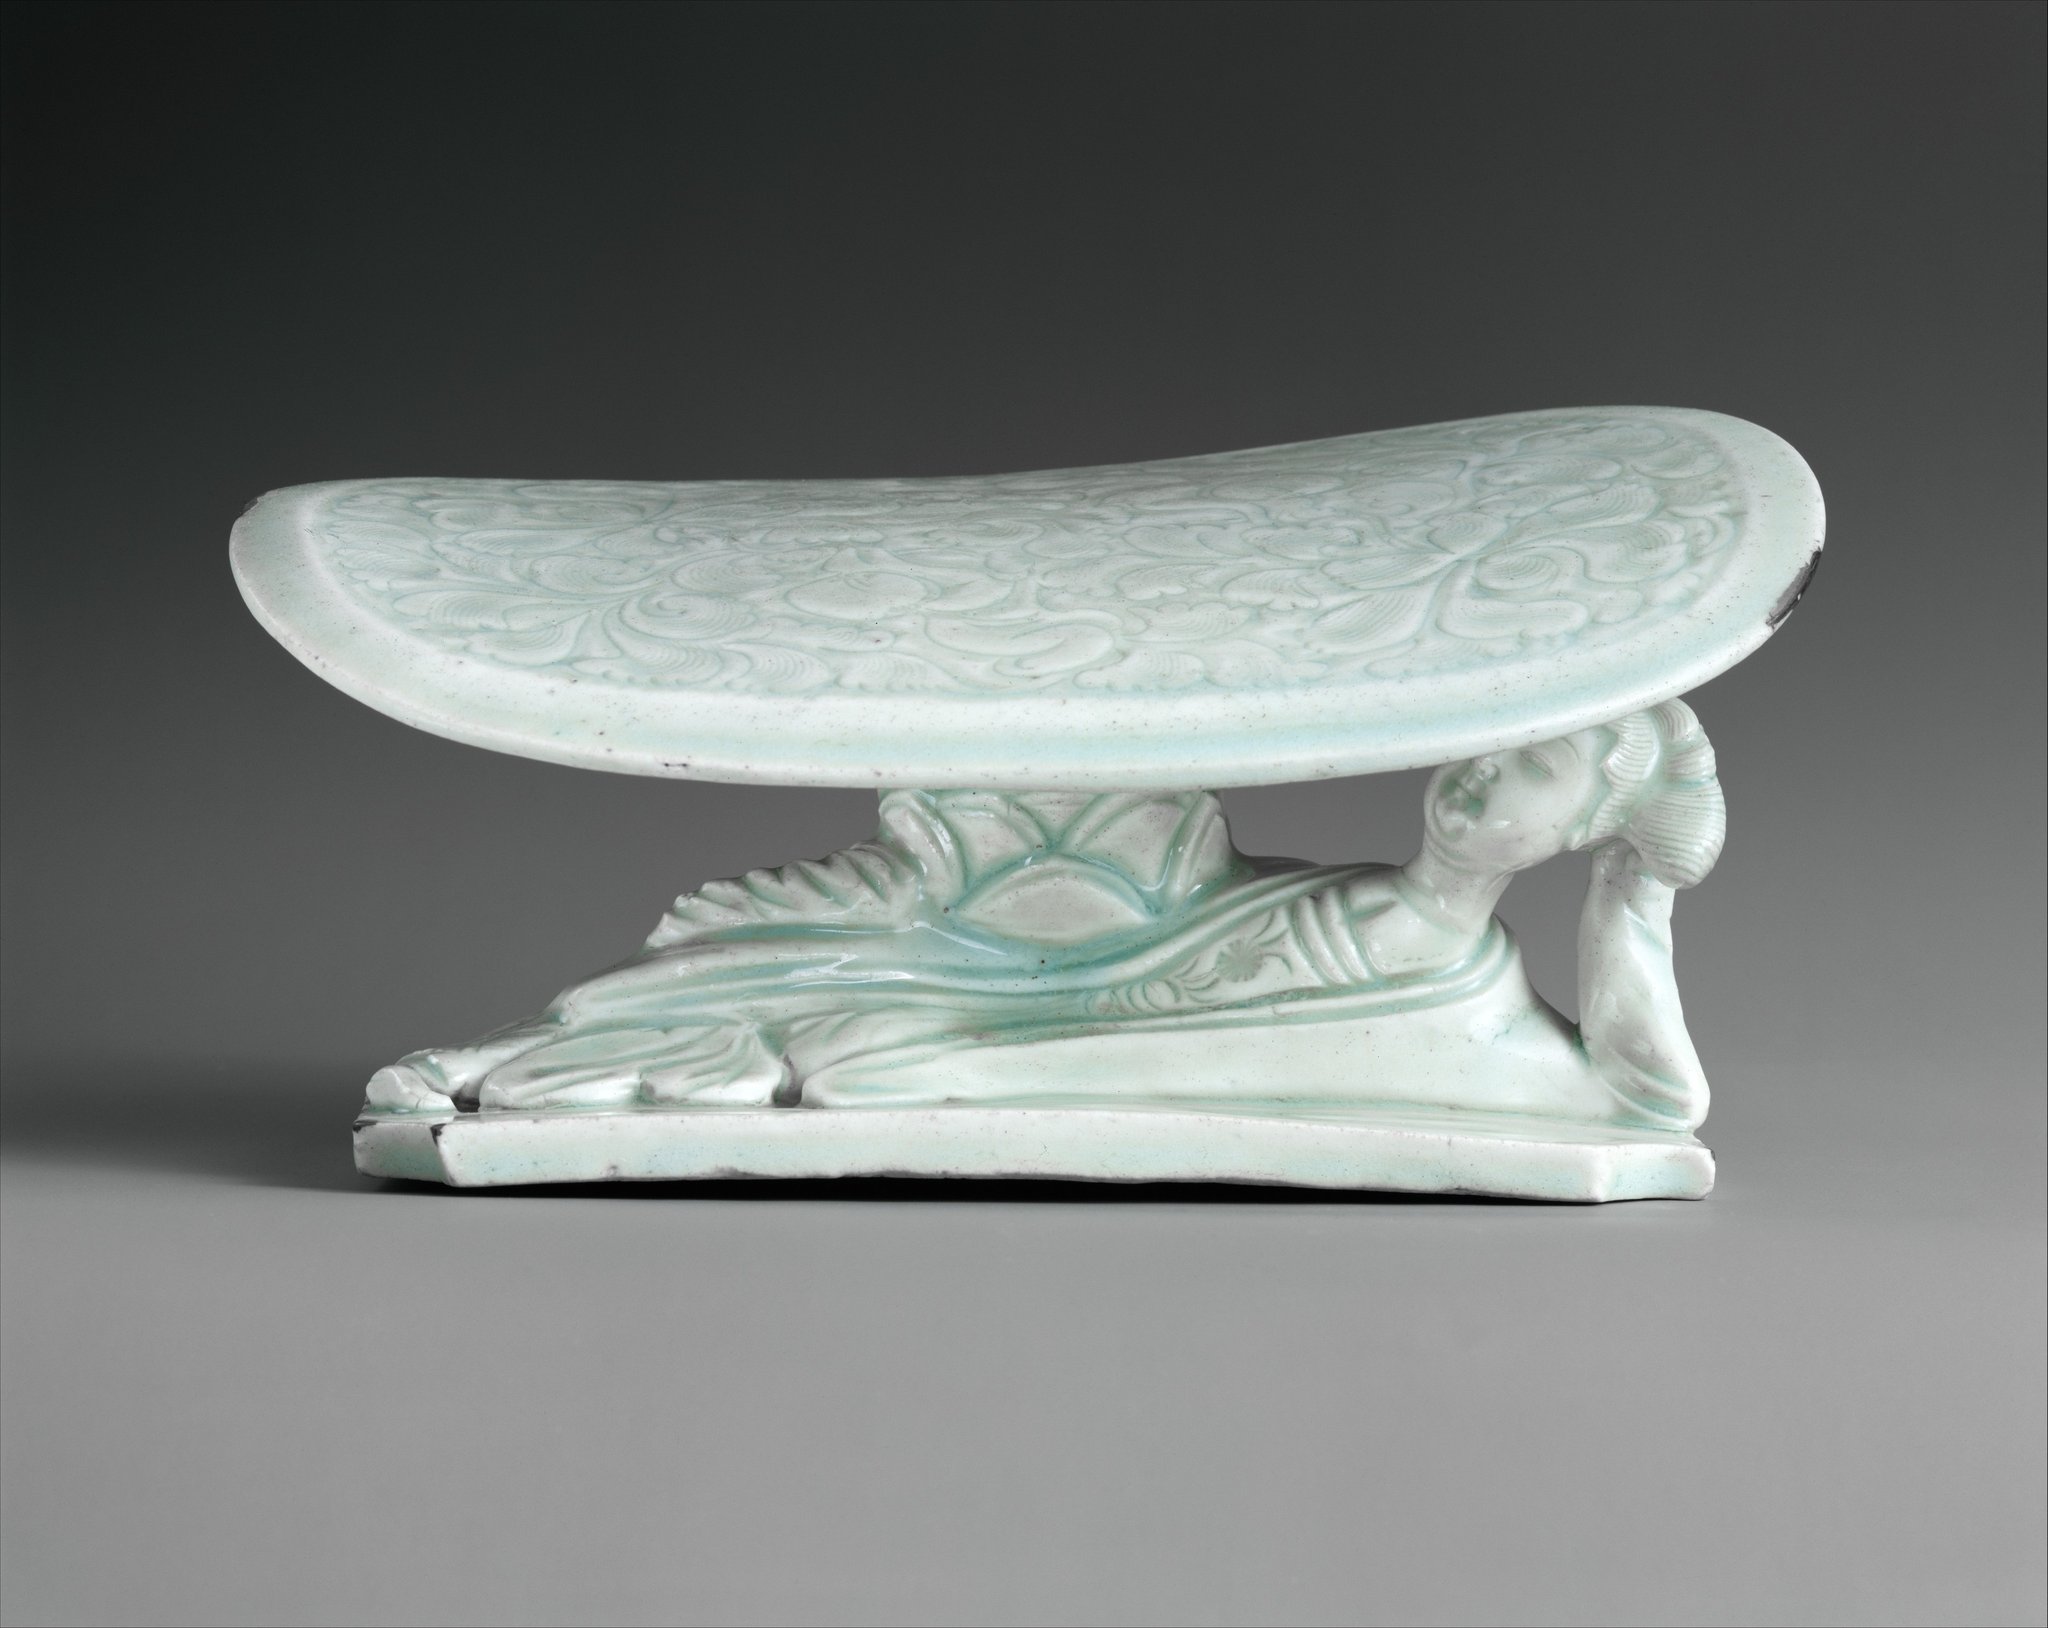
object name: pillow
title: Pillow in Shape of Reclining Woman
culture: chinese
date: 1101-1300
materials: ceramic glaze, glaze, porcelain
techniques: carving, incising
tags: women